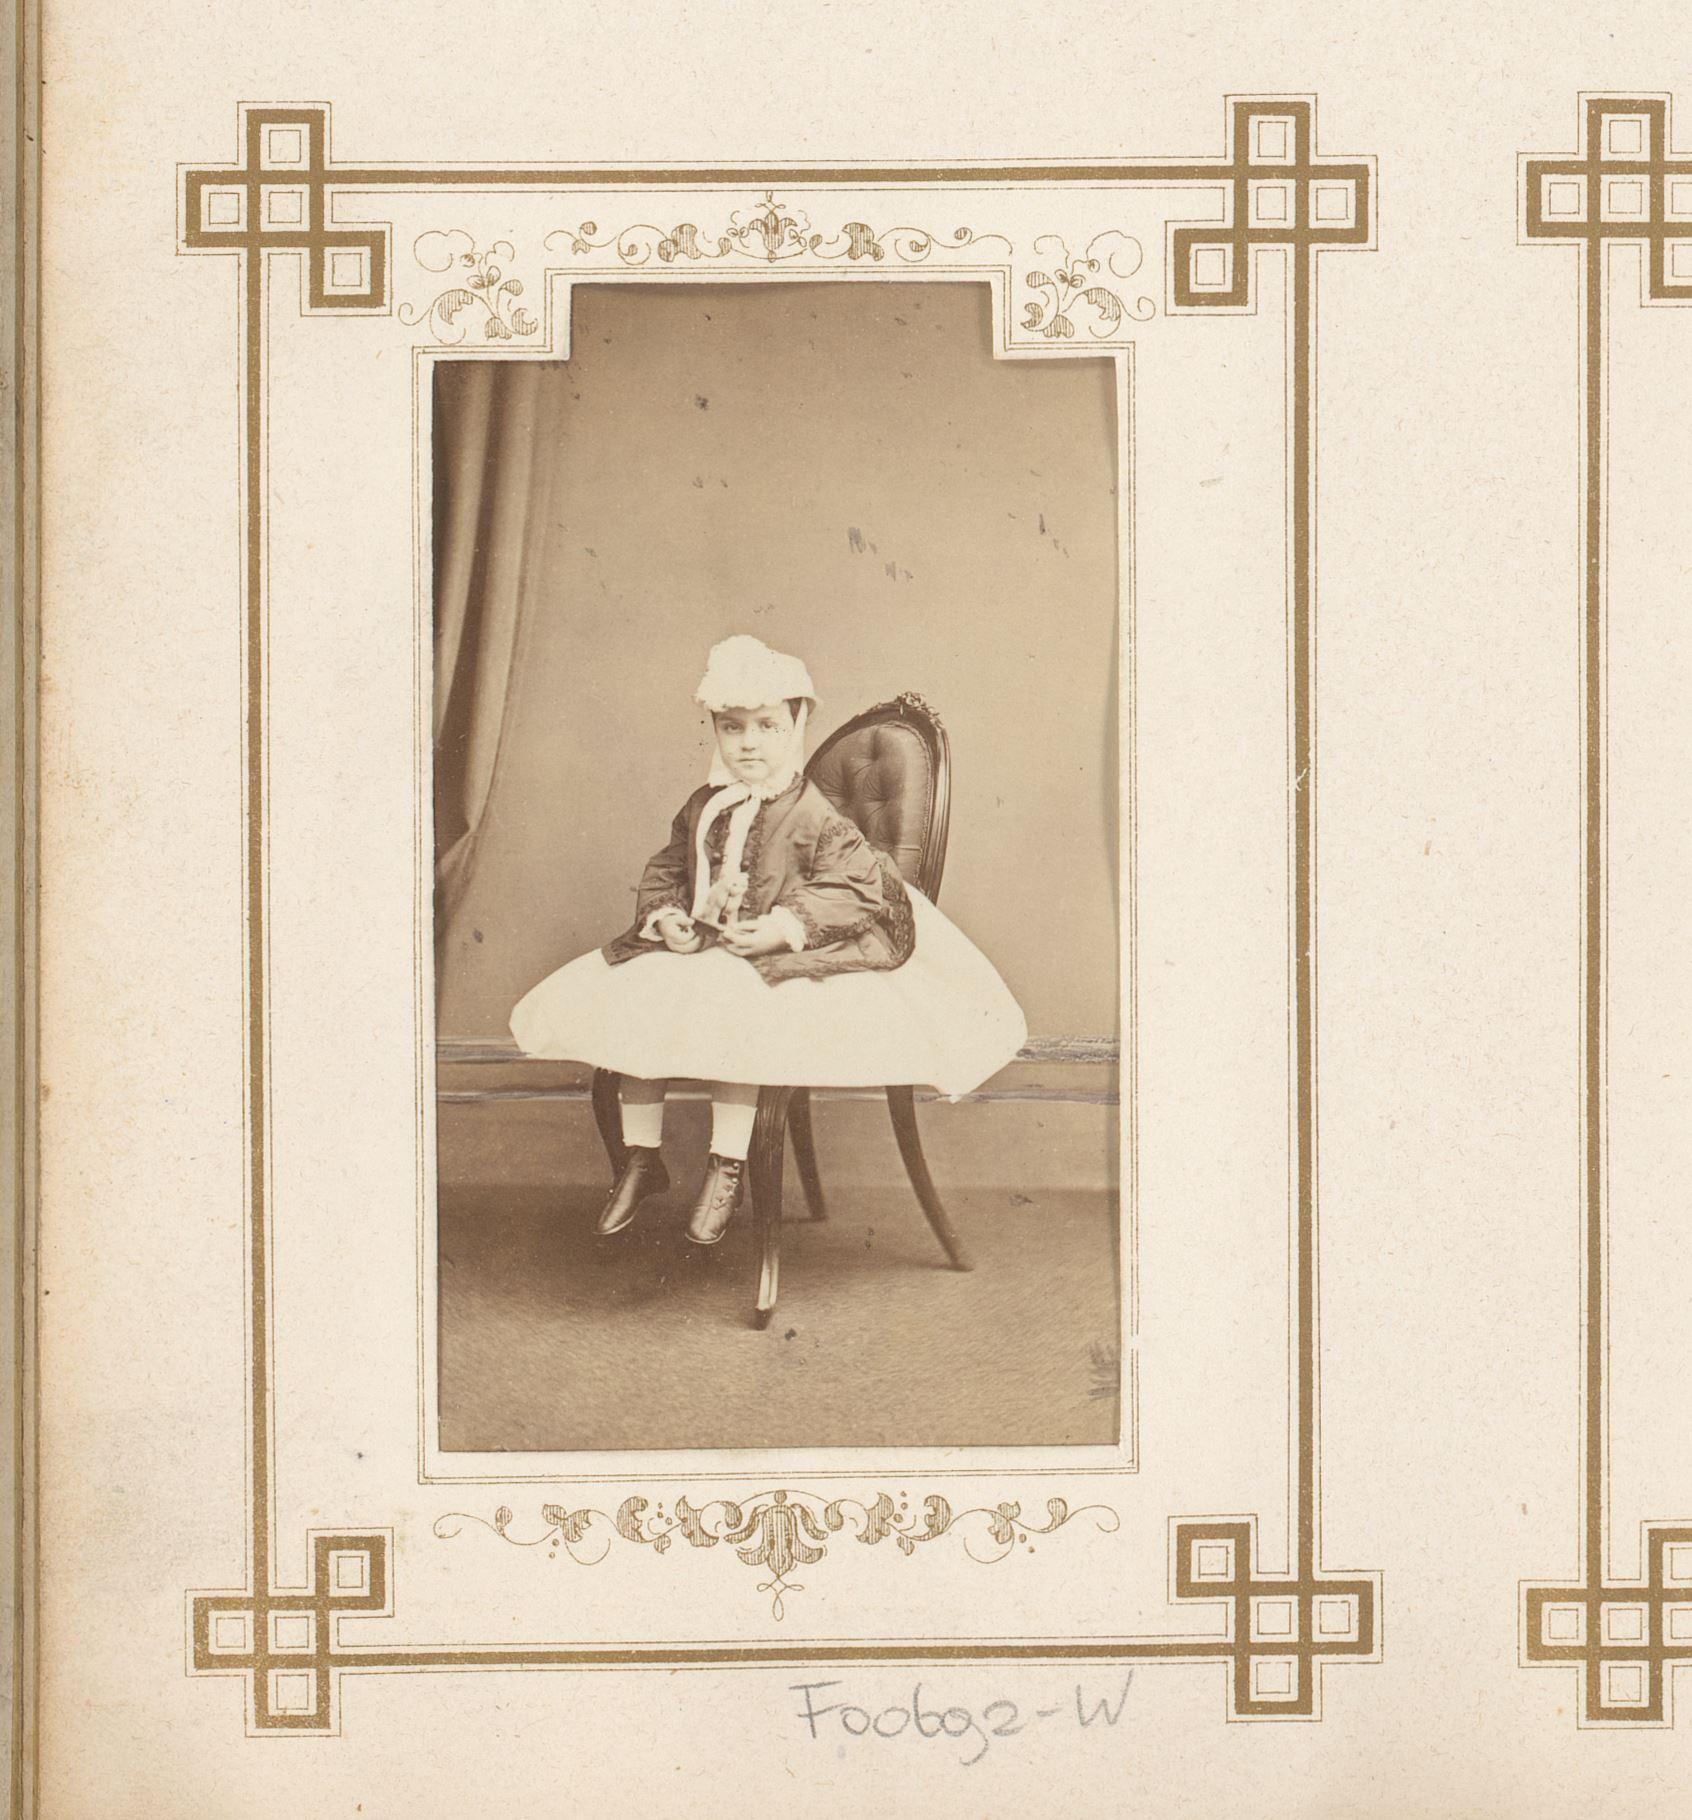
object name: album leaf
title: Portret van een zittend meisje met muts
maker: edward sims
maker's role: fotograaf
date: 1860-1870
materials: cardboard, photographic support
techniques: albumen print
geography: tunbridge wells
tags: girl (child between toddler and youth), head-gear: cap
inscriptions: inscription: ‘Edward Sims/ Photographer/ 3, Culverton Colonade/ London Road/ Tunbridge Wells’